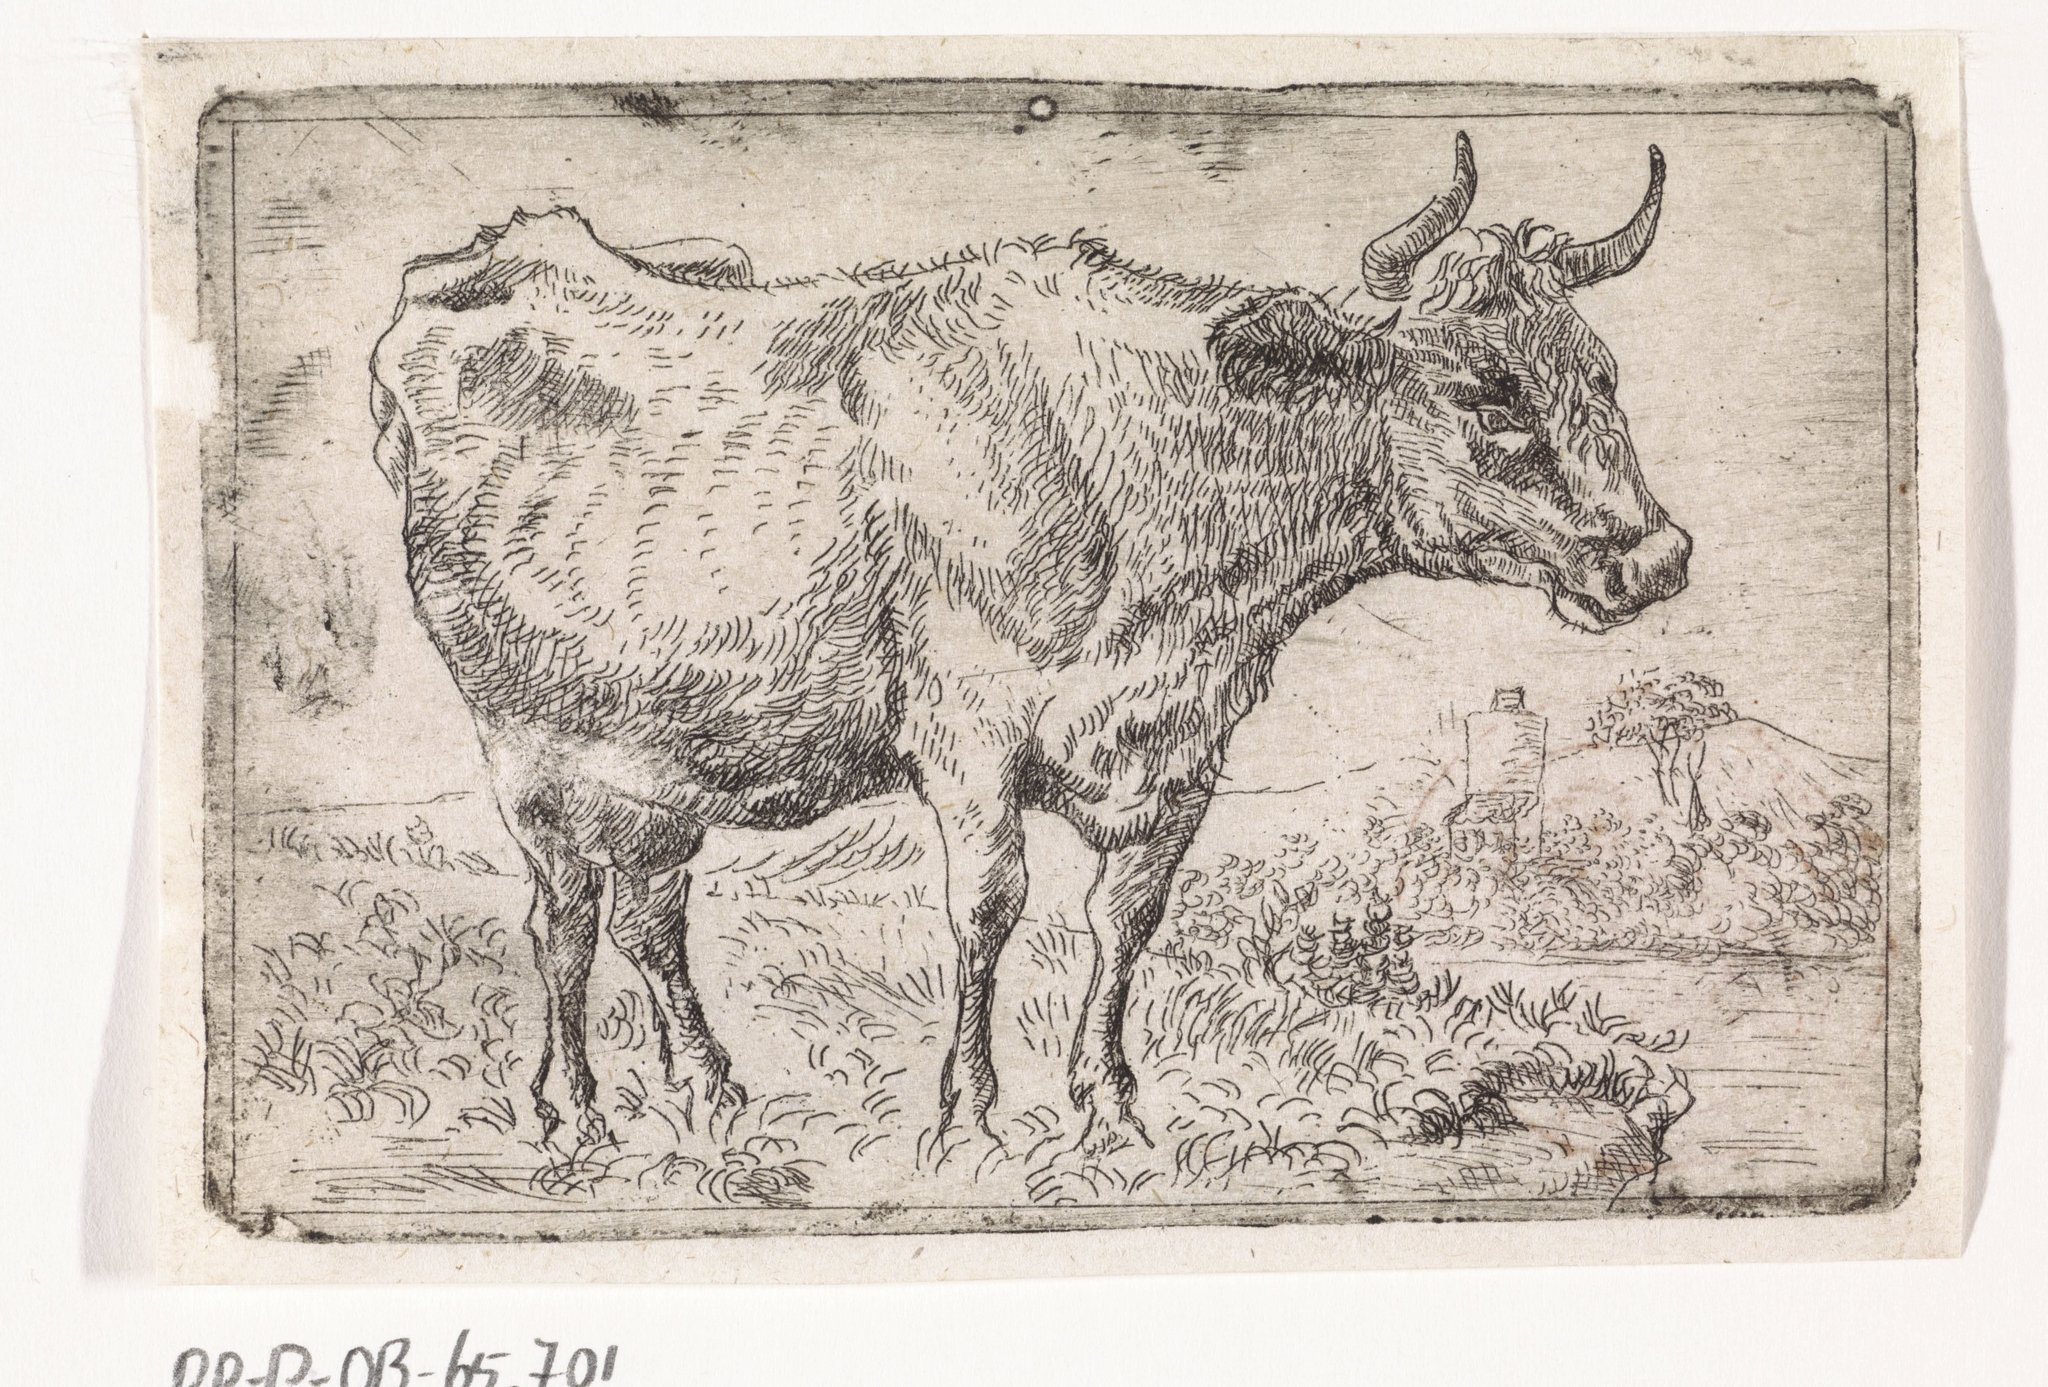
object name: print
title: Koe aan de oever van een rivier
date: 1657-1688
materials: paper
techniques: etching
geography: netherlands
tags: cow, river bank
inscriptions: collector's mark: Lugt 240